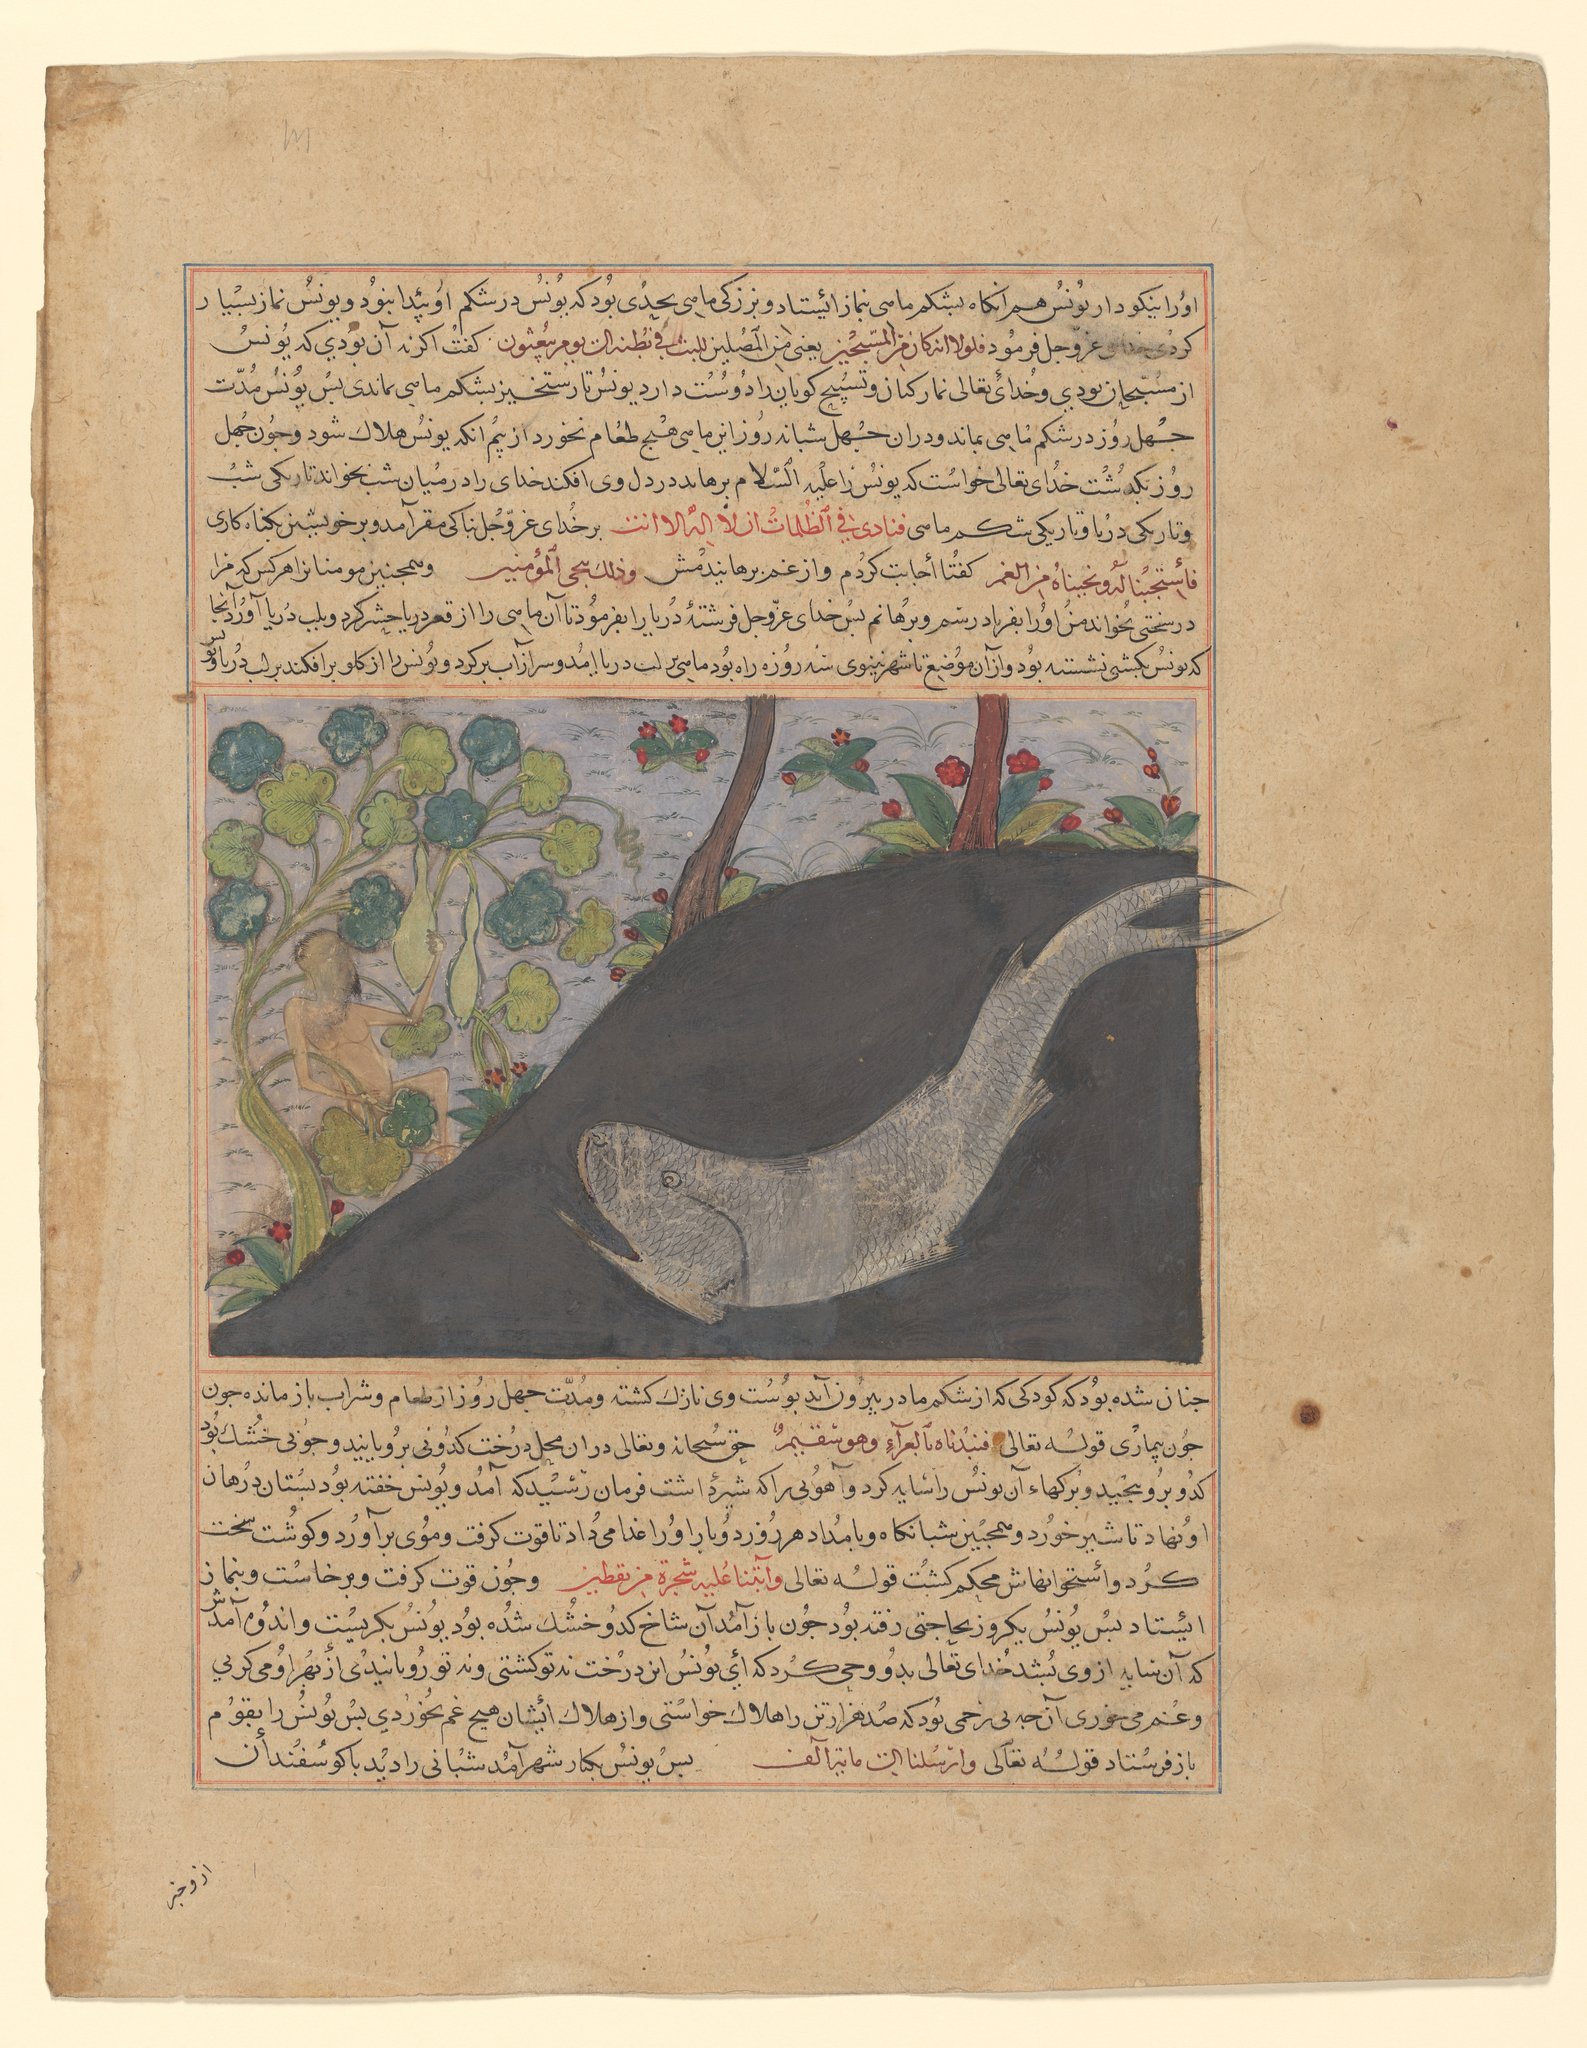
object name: folio from an illustrated manuscript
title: "Jonah and the Whale", Folio from a Majma' al-Tavarikh (Compendium of Histories) of Hafiz-i Abru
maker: hafiz-i abru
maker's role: author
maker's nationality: iranian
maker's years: 1350-1430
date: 1425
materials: gold, paper, silver, watercolor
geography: afghanistan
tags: men,whales